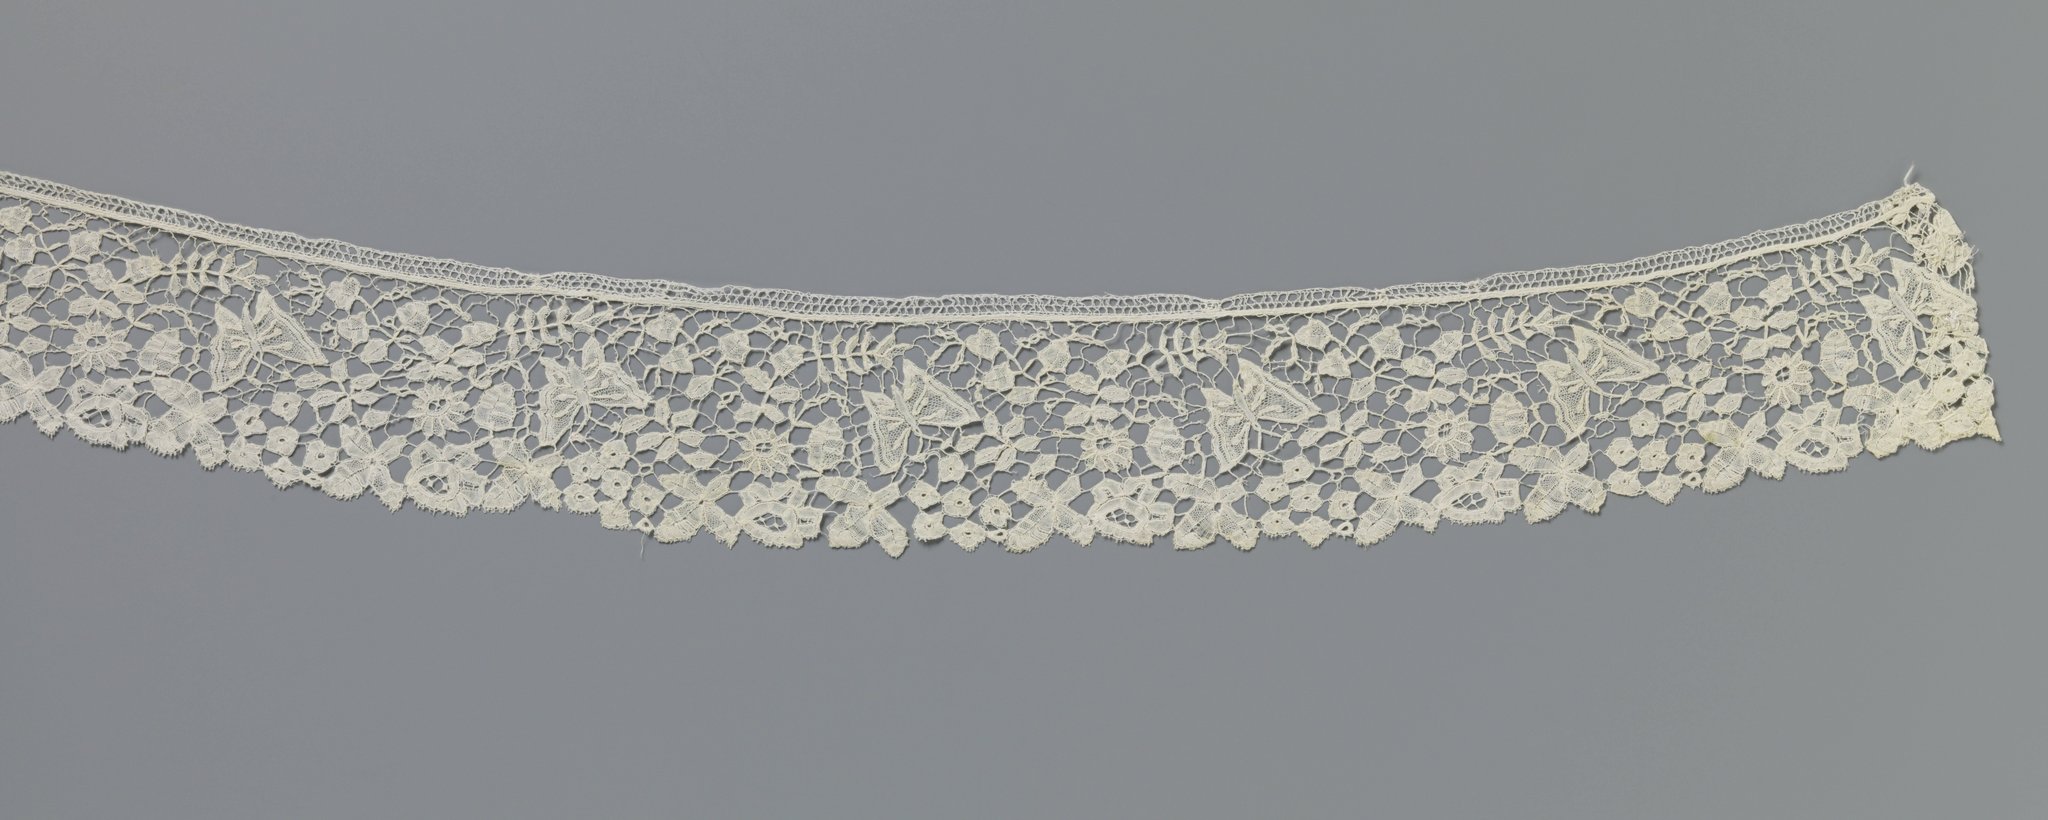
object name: strip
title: Strook kloskant met vlinders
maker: Anonymous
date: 1850-1899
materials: cotton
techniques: lace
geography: honiton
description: Strook naturelkleurige kloskant, Honiton-kant. Het zich herhalende patroon bestaat uit bloemen en bladeren in verschillende soorten en maten waartussen een vlinder naar beneden fladdert. De motieven zijn met elkaar verbonden door gepicoteerde vlechten. De motieven zijn gemaakt in dichtgewerkte linnenslag en in netslag, met fijne opengewerkte randjes en uitsparingen. De motieven zijn geaccentueerd met contourdraden en gekloste reliëfcontouren. In enkele opengewerkte bloemharten staan één of meerdere vierkantjes gemaakt in vormslag. De bovenzijde van de strook is afgewerkt met een apart geklost bandje. De schulpenrand langs de onderzijde volgt de vormen van de onderste rij bloemen en bladeren en is afgewerkt met picots. De korte zijden zijn afgewerkt met een zoompje waarop enkele drukknoopjes zijn genaaid.